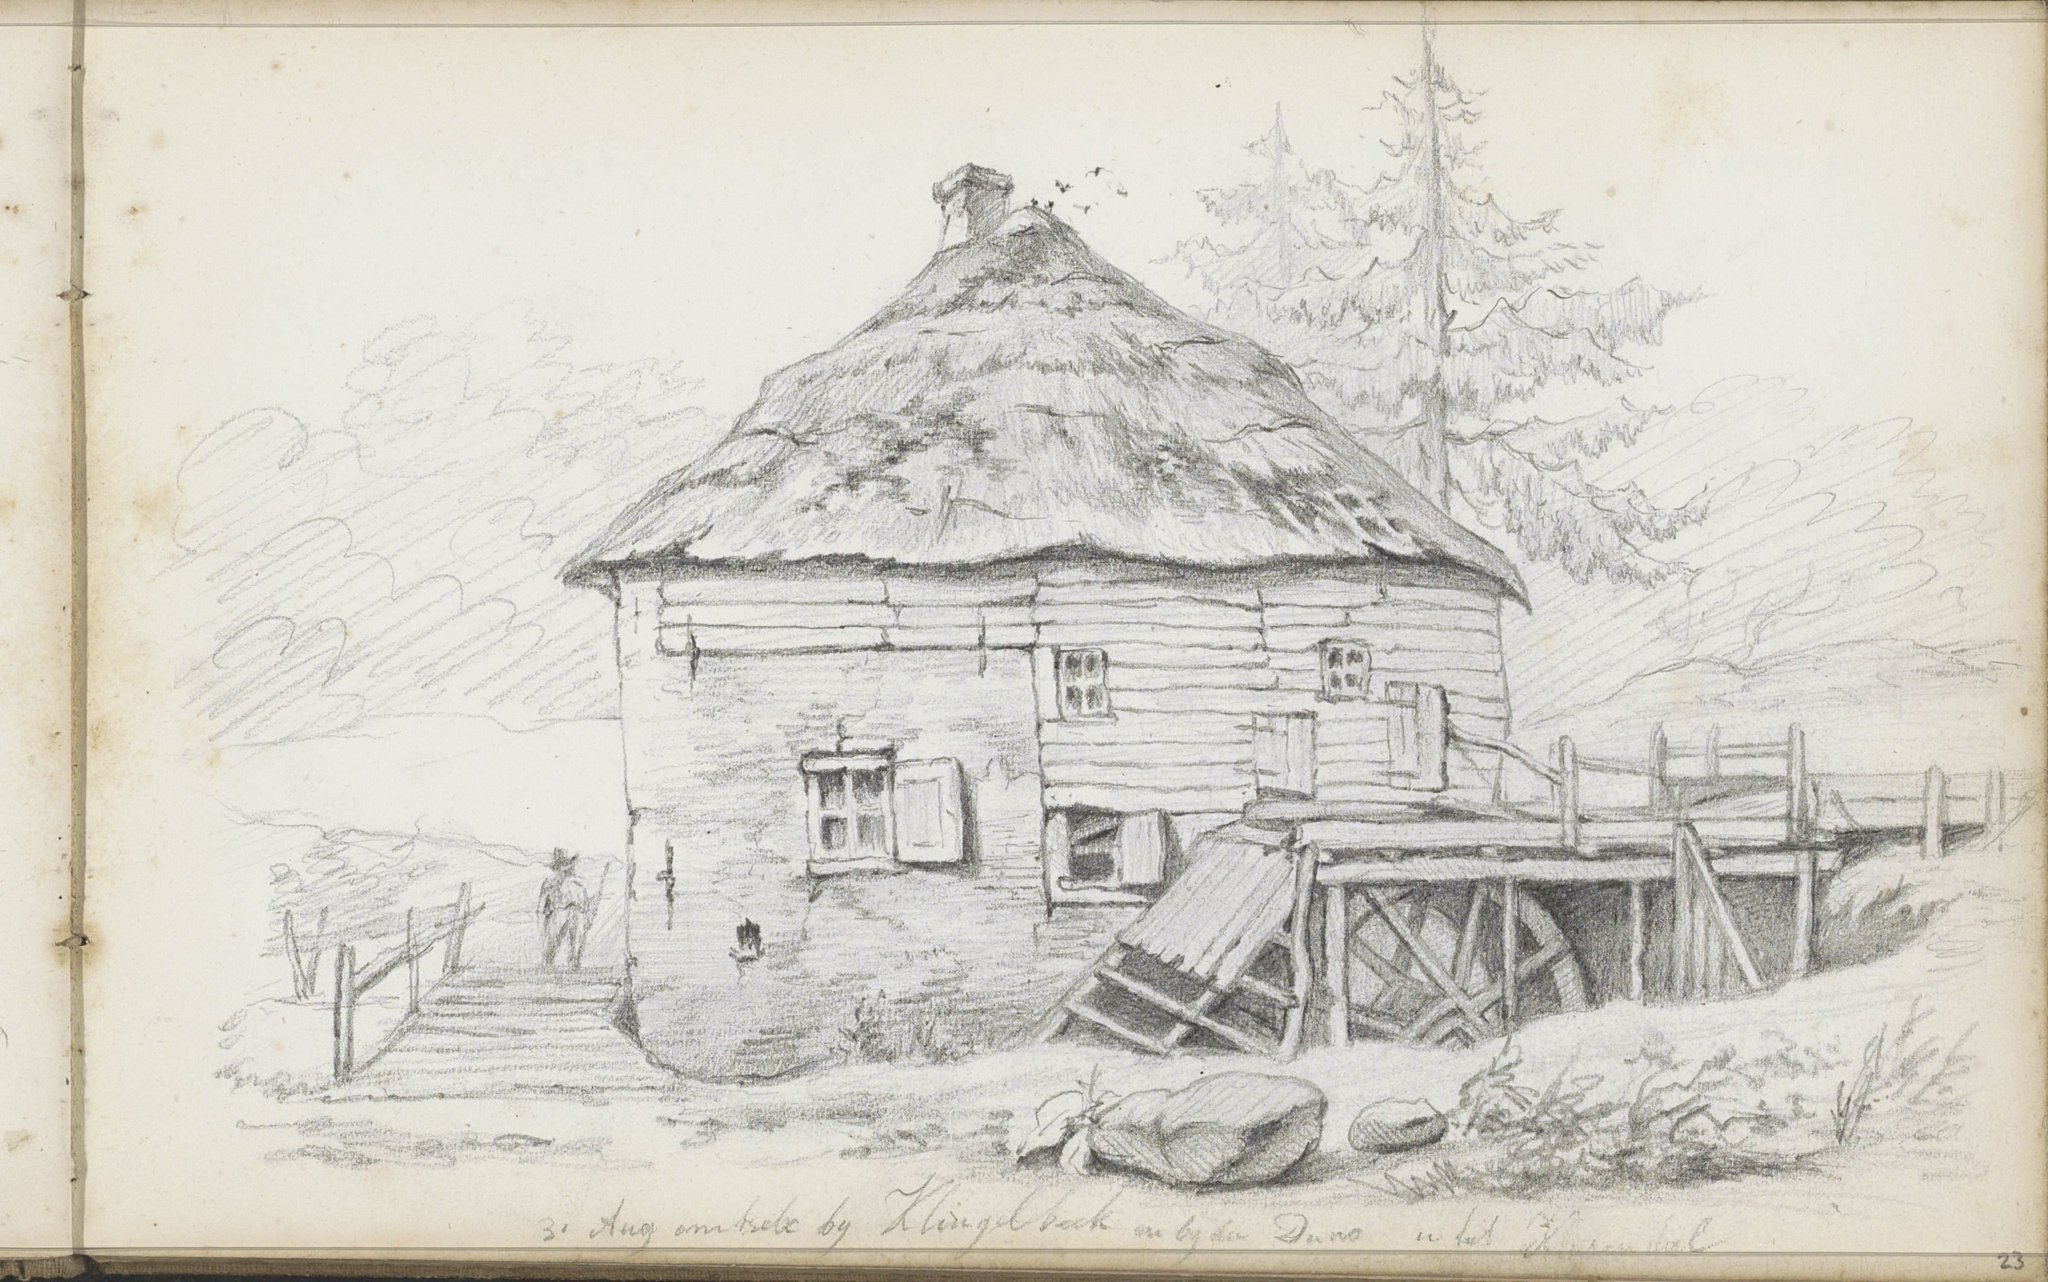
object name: sketchbook leaf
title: Watermolen bij Klingelbeek en Klarendal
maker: willem cornelis rip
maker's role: draughtsman, painter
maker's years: 1856-1922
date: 1808-1874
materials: paper, pencil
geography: klingelbeek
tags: watermill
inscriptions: date and inscription: ‘31 Aug omtrek bij Klingelbeek en bij den D[...] [...]n het Klarendal’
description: Op de brug naast de molen staat een man. Blad 23 recto uit een schetsboek met 47 bladen.